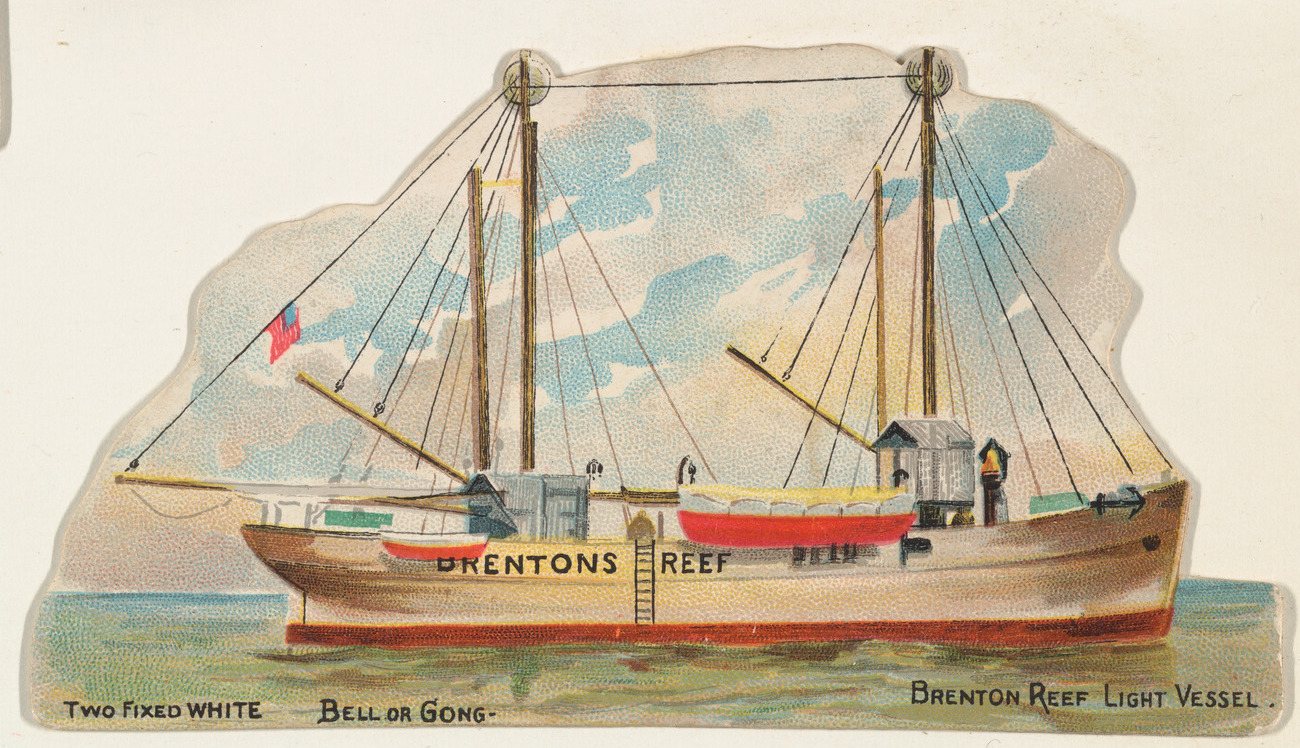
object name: print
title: Brenton Reef Light Vessel, from the Lighthouses series (N119) issued by Duke Sons & Co. to promote Honest Long Cut Tobacco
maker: w. duke, sons & co.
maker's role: publisher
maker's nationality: american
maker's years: 1870-1920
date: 1889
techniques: color lithograph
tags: ships